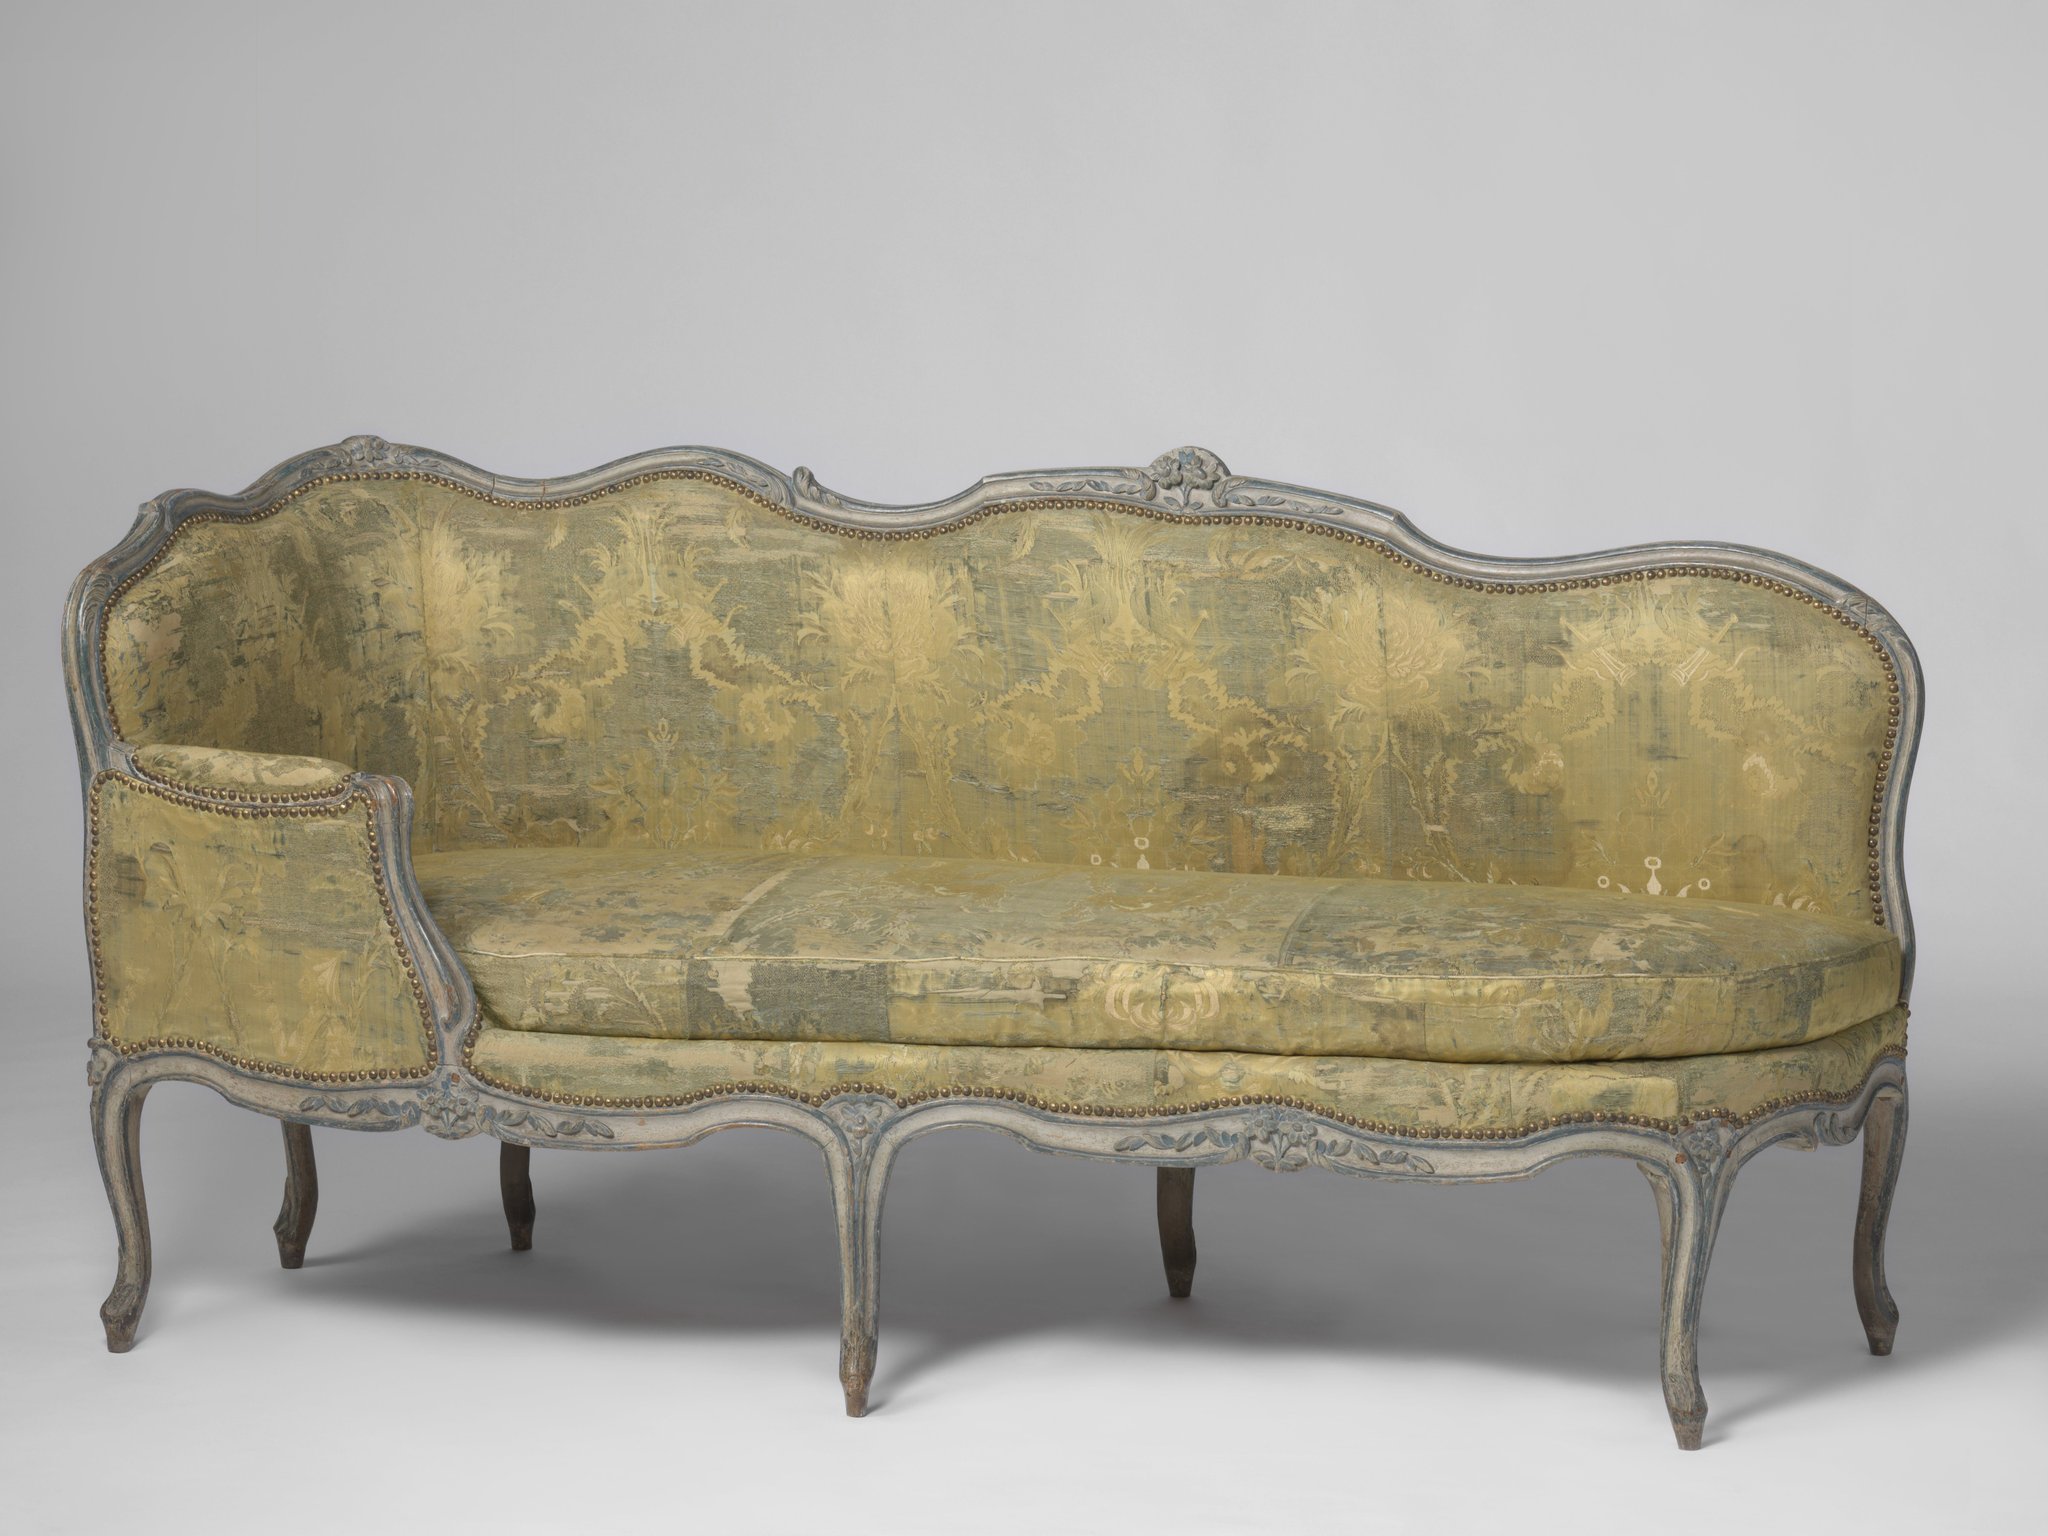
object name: sofa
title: Canapé bekleed met zijde met patroon van Chinese figuren op geel fond.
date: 1750-1760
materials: wood, silk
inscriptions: stamp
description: Settee. Beech. Paris, c. 1750, by Jean Nadal.